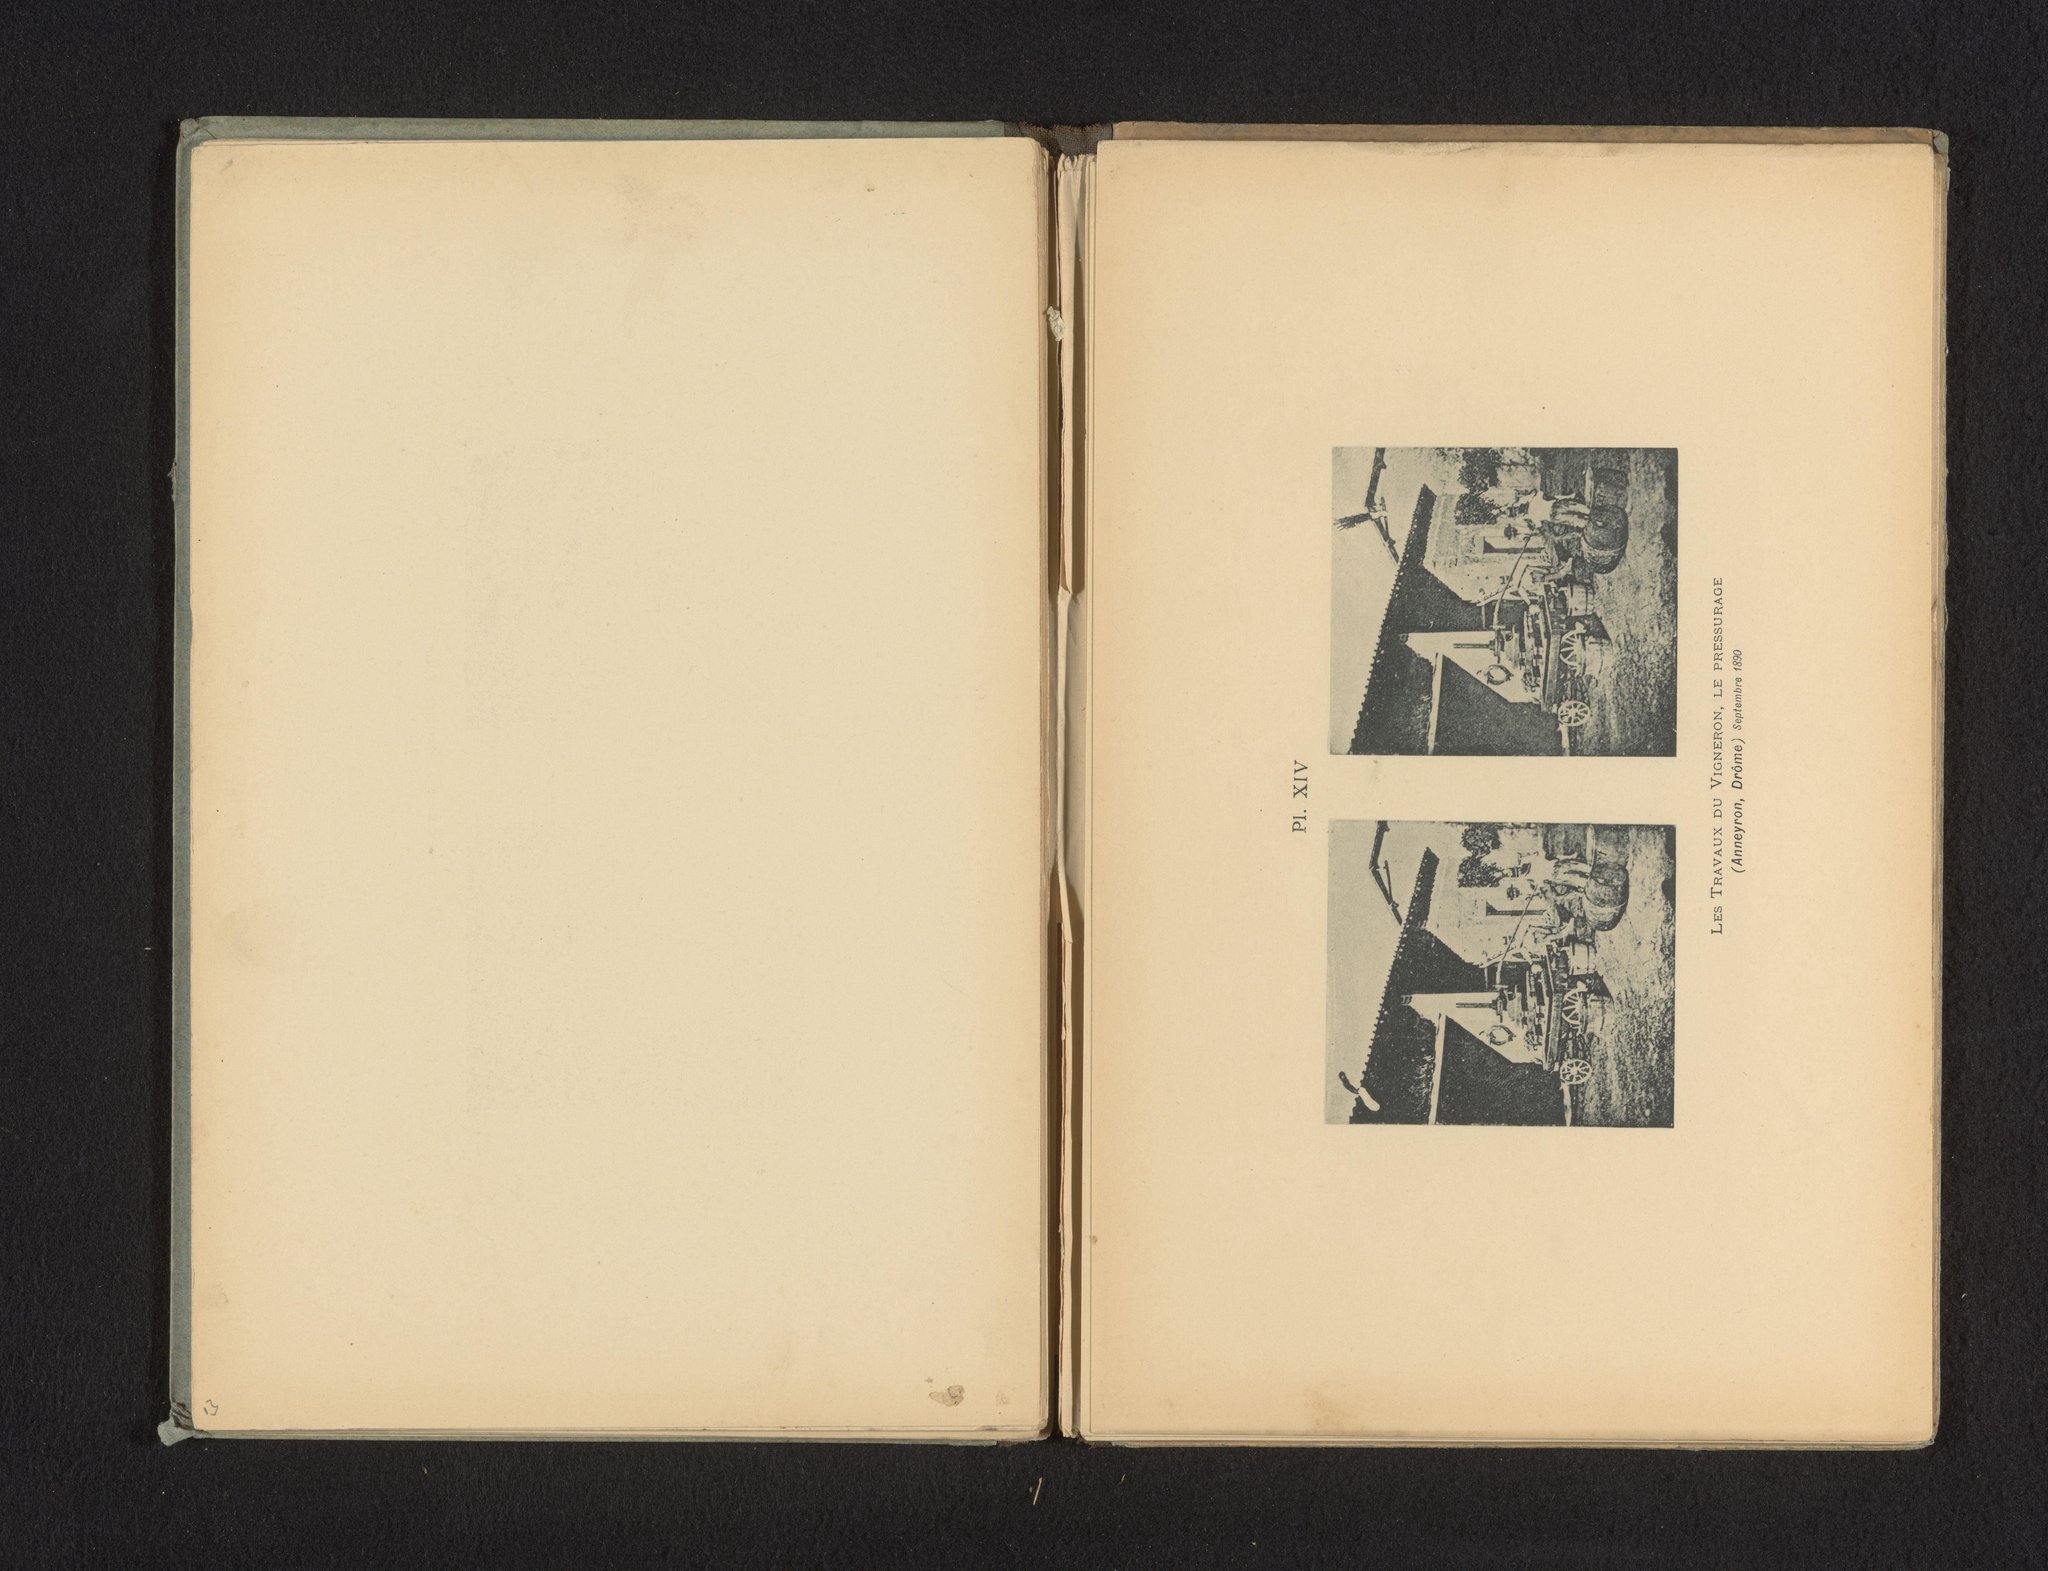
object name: page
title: Stereofoto van het persen van druiven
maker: adolphe louis donnadieu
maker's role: wetenschapper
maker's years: 1840-1911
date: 1882-1892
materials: paper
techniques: photograph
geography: drôme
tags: pressing grapes, landscape with bridge, viaduct or aqueduct (+ city(-scape) with figures, staffage)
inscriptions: inscription: ‘(Anneyron, Drôme) Septembre 1890’, inscription: ‘Pl. XIV’